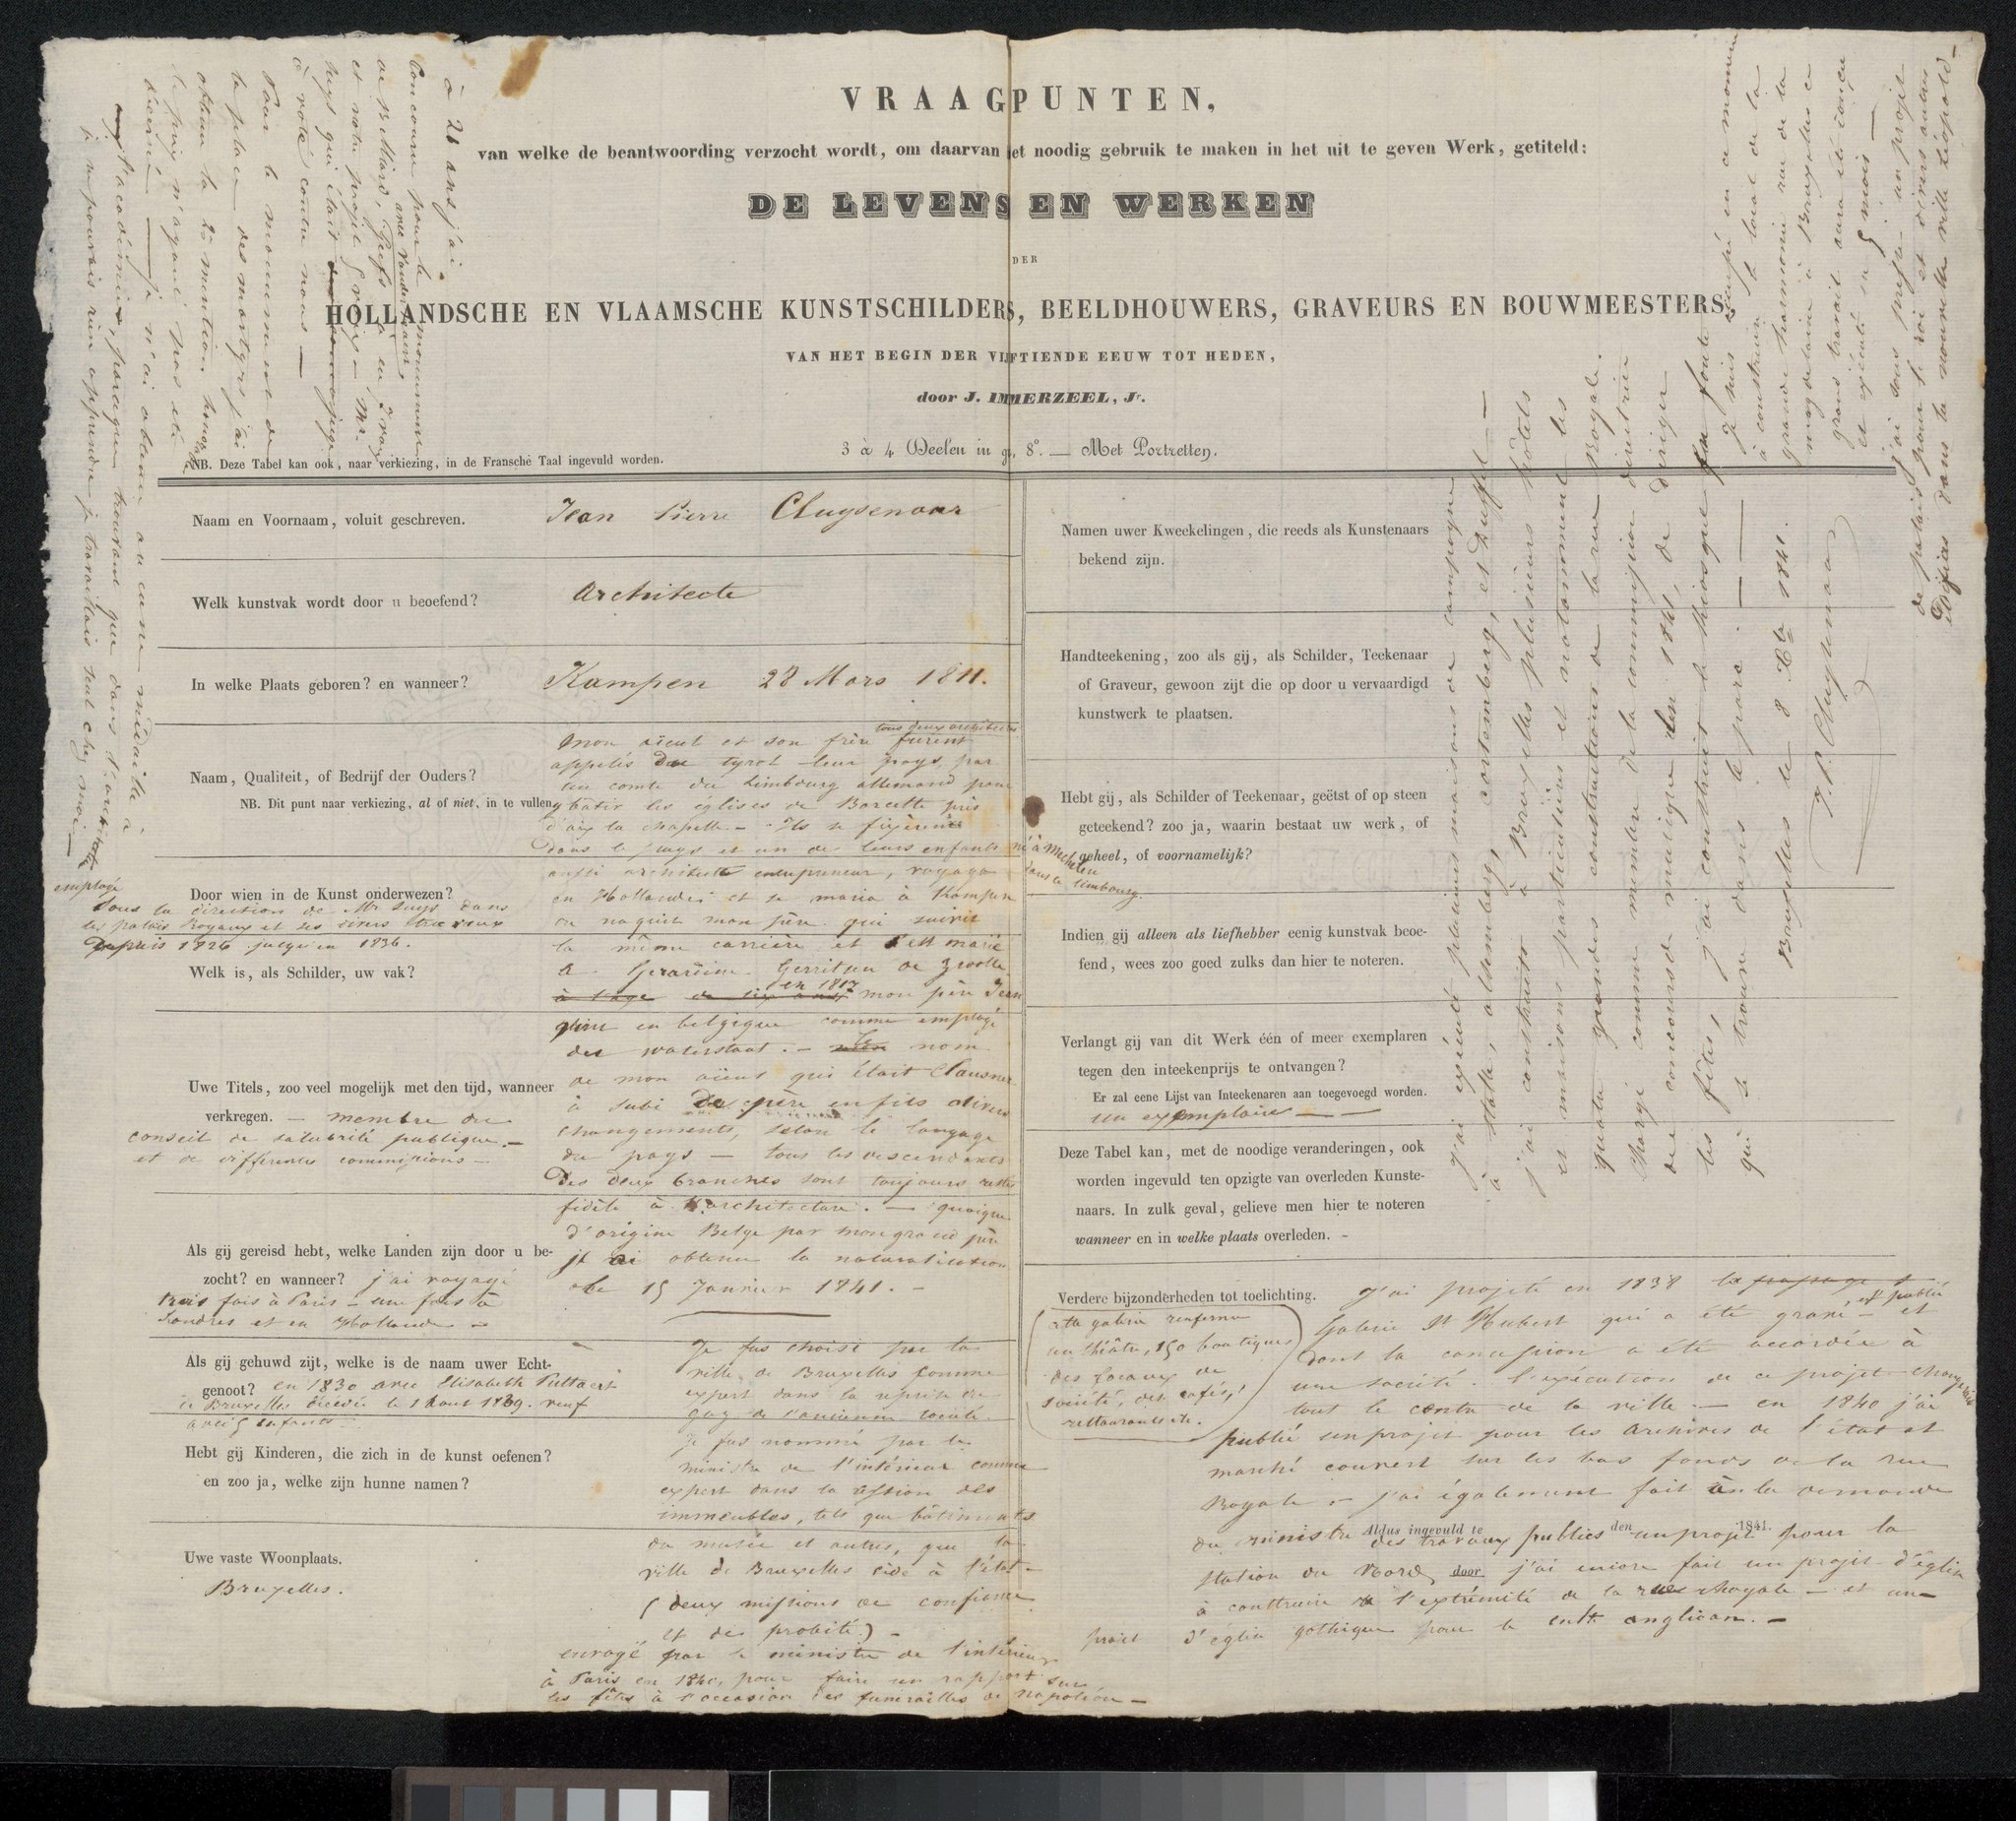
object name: manuscript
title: Enquêteformulier ingevuld door Jean Pierre Cluysenaar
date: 1841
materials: ink, paper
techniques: pen, printing, writing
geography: brussels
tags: brussels, draughtsman, jean pierre cluysenaar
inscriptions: inscription: ‘Vraagpunten,/ van welke de beantwoording verzocht wordt, om daarvan het noodig gebruik te maken in het uit te geven Werk, getiteld: De levens en werken/ der Hollandsche en Vlaamsche kunstschilders, beeldhouwers,/ graveurs en bouwmeesters, van het begin der vijftiende eeuw tot heden/ door J. Immerzeel, Jr.’, watermark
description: Opgenomen in: Immerzeel, J. Jr., De levens en werken der Hollandsche en Vlaamsche kunstschilders, beeldhouwers, graveurs en bouwmeesters, van het begin der vijftiende eeuw tot heden, Amsterdam: J.C. van Kesteren, 1842-1843.